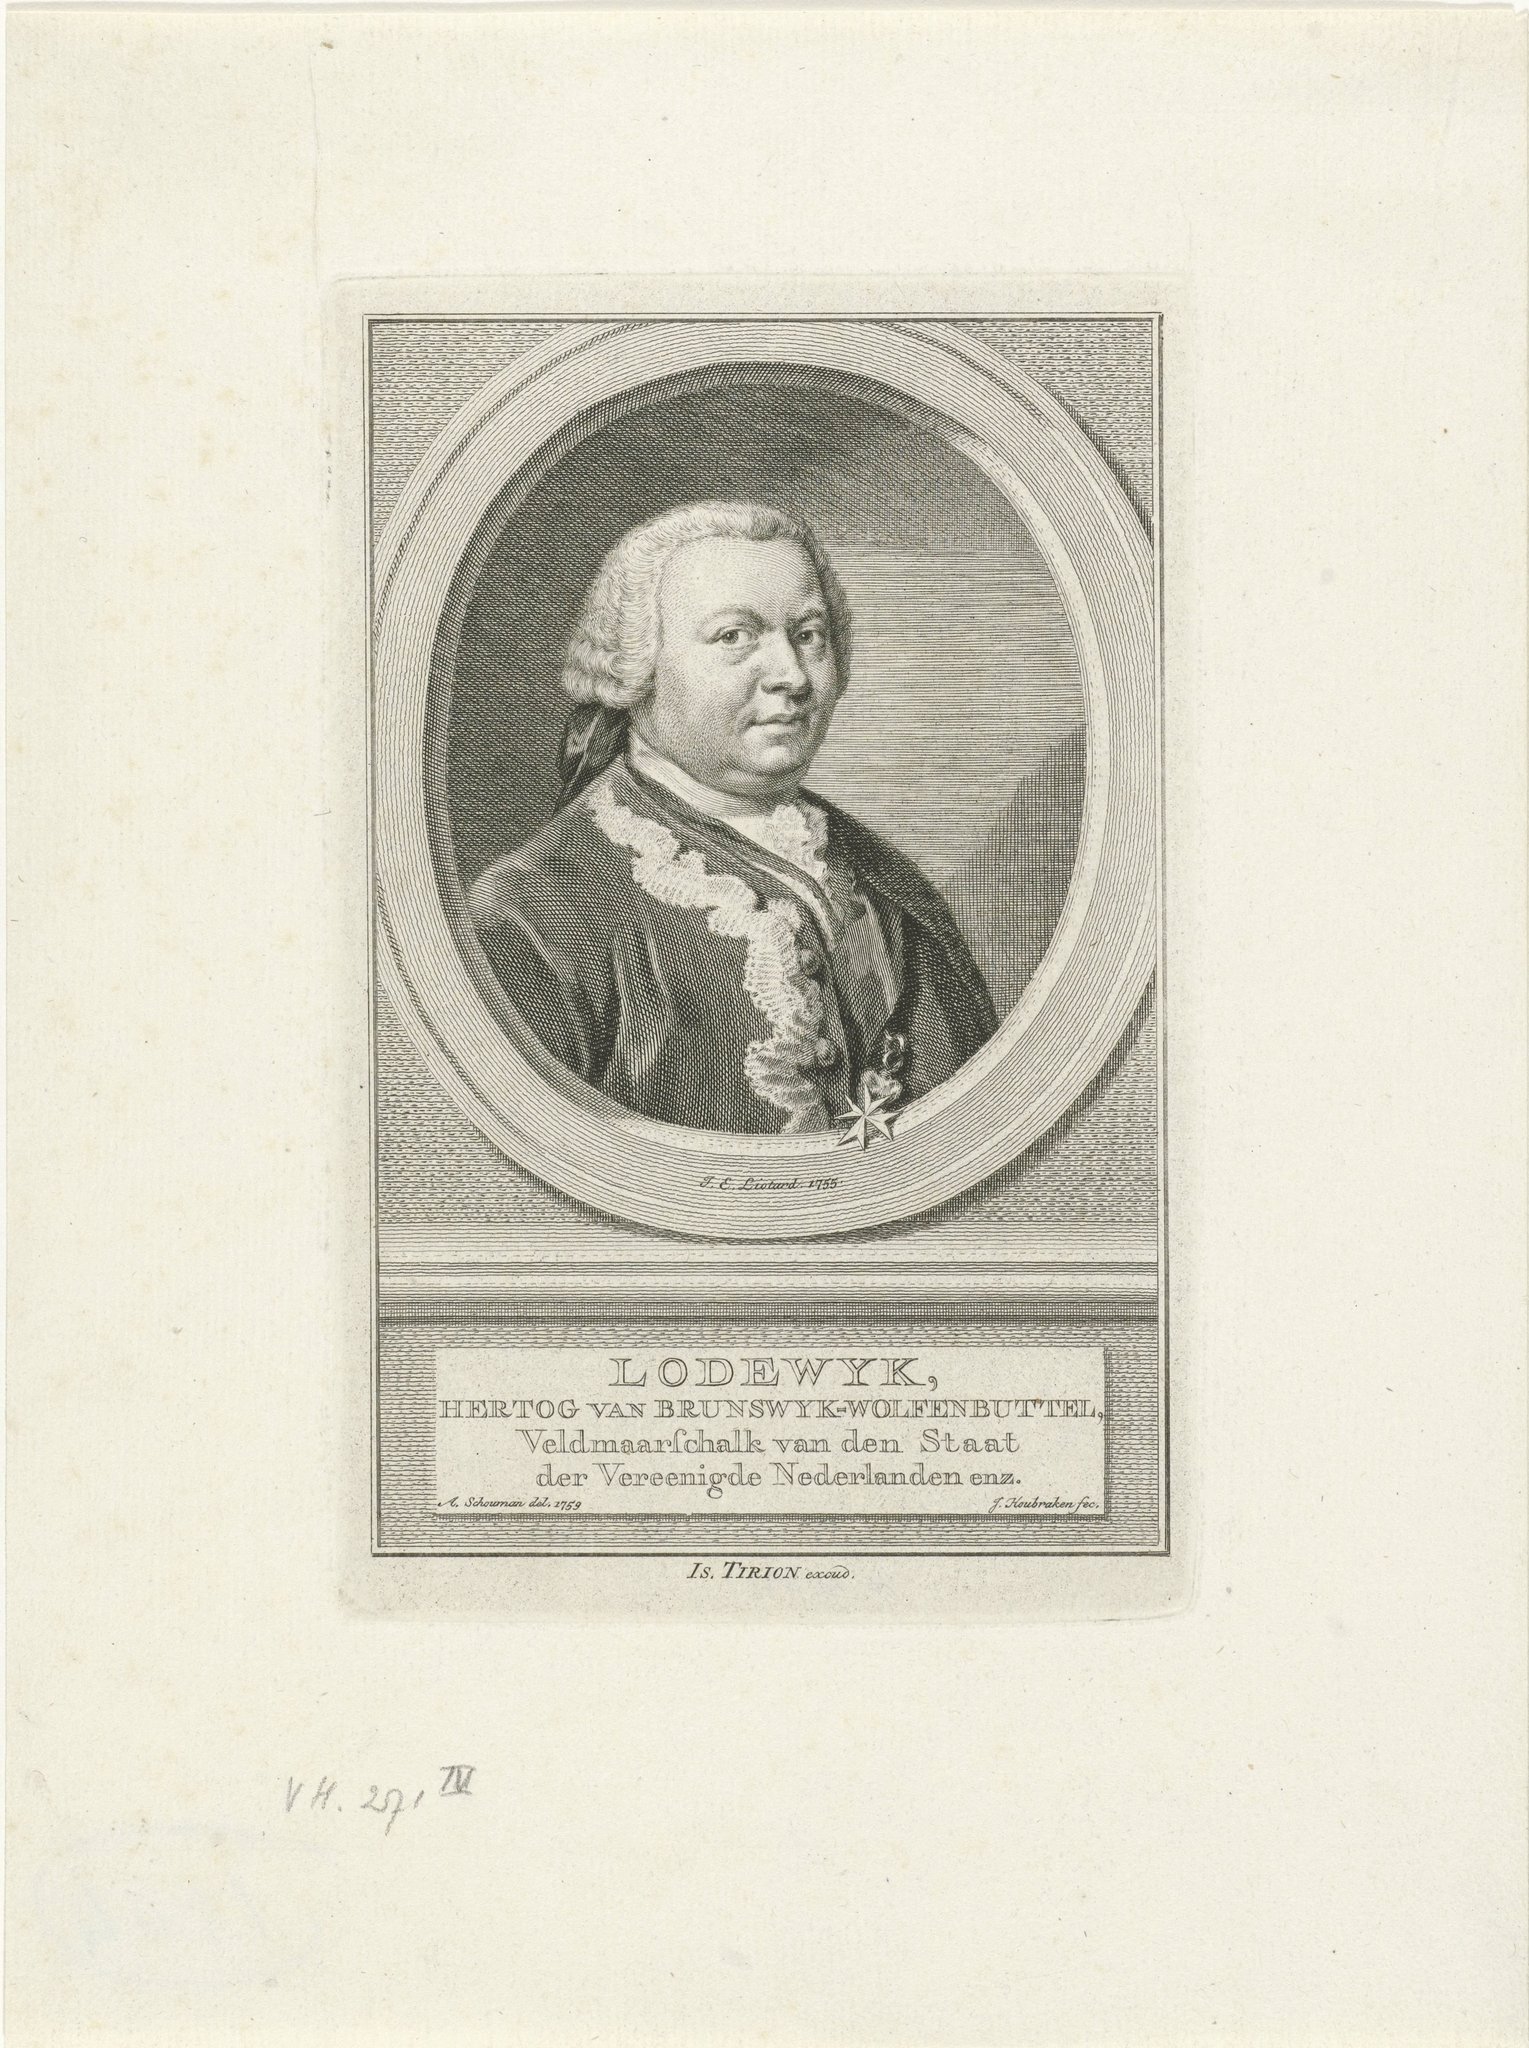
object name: print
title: Portret van Lodewijk Ernst, hertog van Brunswijk-Wolfenbüttel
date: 1759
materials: paper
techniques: engraving, etching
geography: amsterdam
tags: ludwig ernst von braunschweig-wolfenbüttel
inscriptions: collector's mark: Lugt 2228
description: Prent ook gebruikt in: Jan Wagenaar, Vaderlandsche historie, vervattende de geschiedenissen der nu Vereenigde Nederlanden, inzonderheid die van Holland (...), 21 delen. Amsterdam, Isaak Tirion, 1749-59.